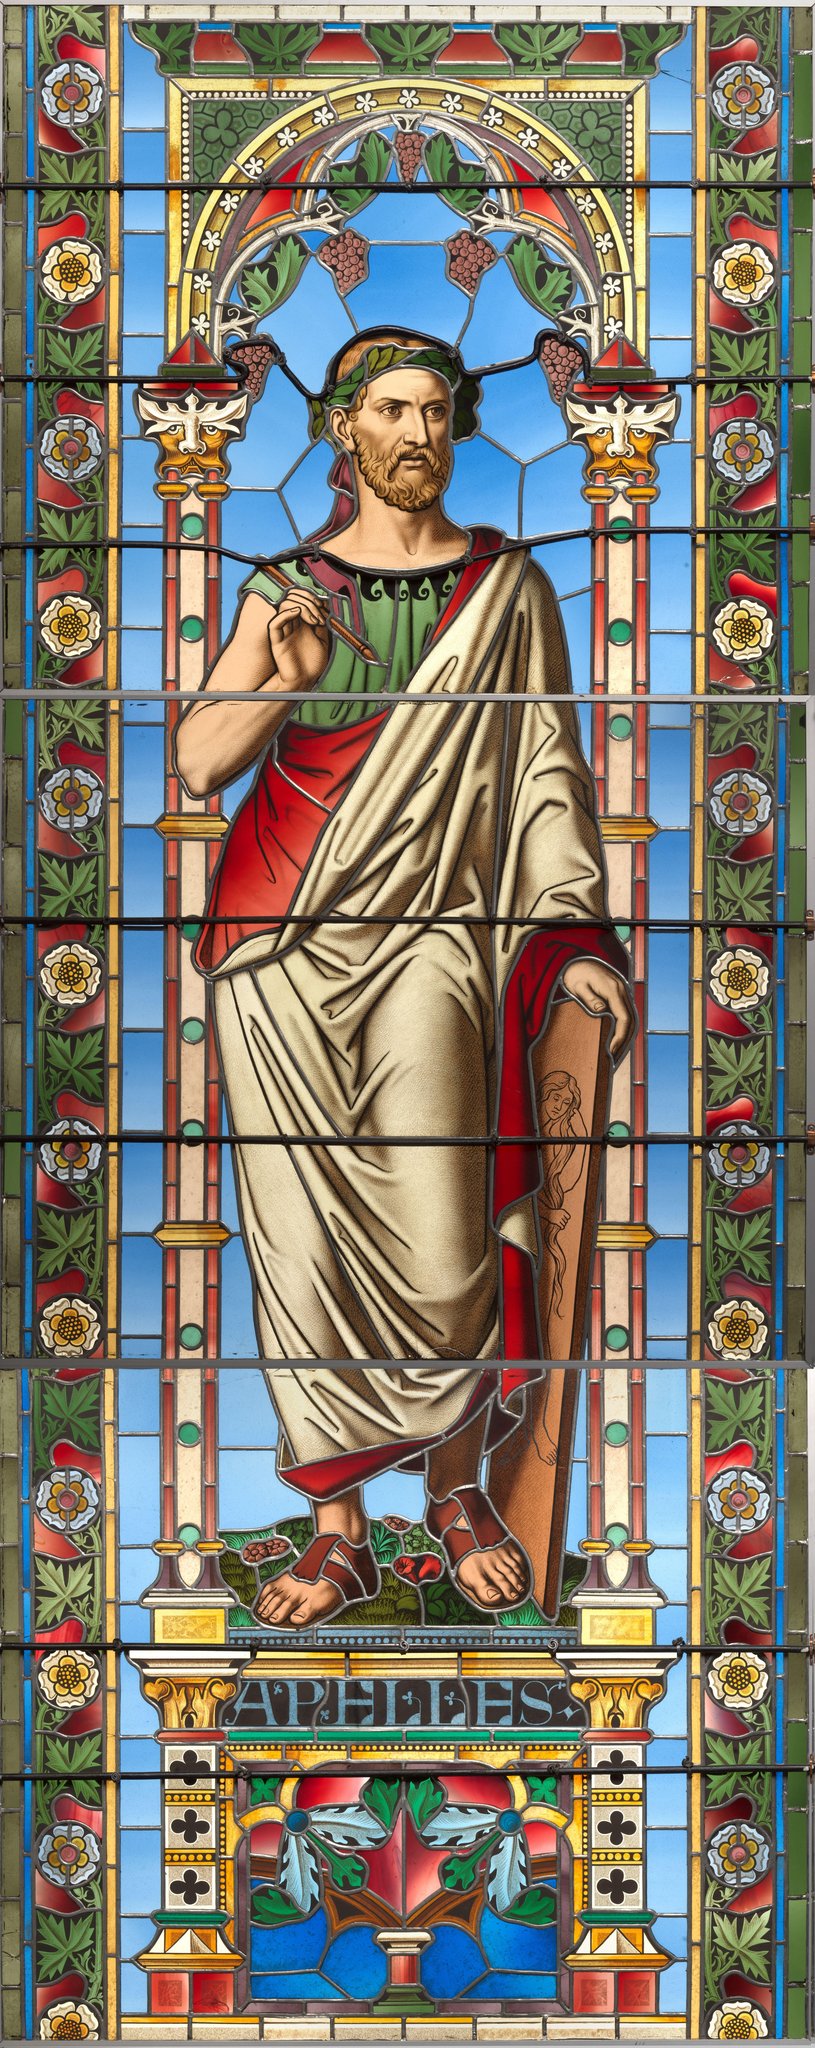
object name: light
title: Raam met voorstelling Apelles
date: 1882-1883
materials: glass, lead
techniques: enamel painting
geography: innsbruck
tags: (story of) apelles, the painter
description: P.J.H. Cuypers schreef in 1882 een prijsvraag uit voor het ontwerpen van gebrandschilderde ramen voor de voorhal van het Rijksmuseum. Hij nodigde zes kunstenaars uit mee te doen en een proefraam met Apelles in te sturen. Vijf van hen gaven hieraan gehoor: W.F. Dixon, H.J.J. Geuer, F. Nicolas, Stalins & Janssens en de Tiroler Glasmalerei und Cathedralenglashuette. Dixon kreeg uiteindelijk de opdracht. Zijn raam werd geplaatst. De vier overige ramen worden bewaard in het Rijksmuseum. Zie ook bij BK-1999-87-A/B/C/D.